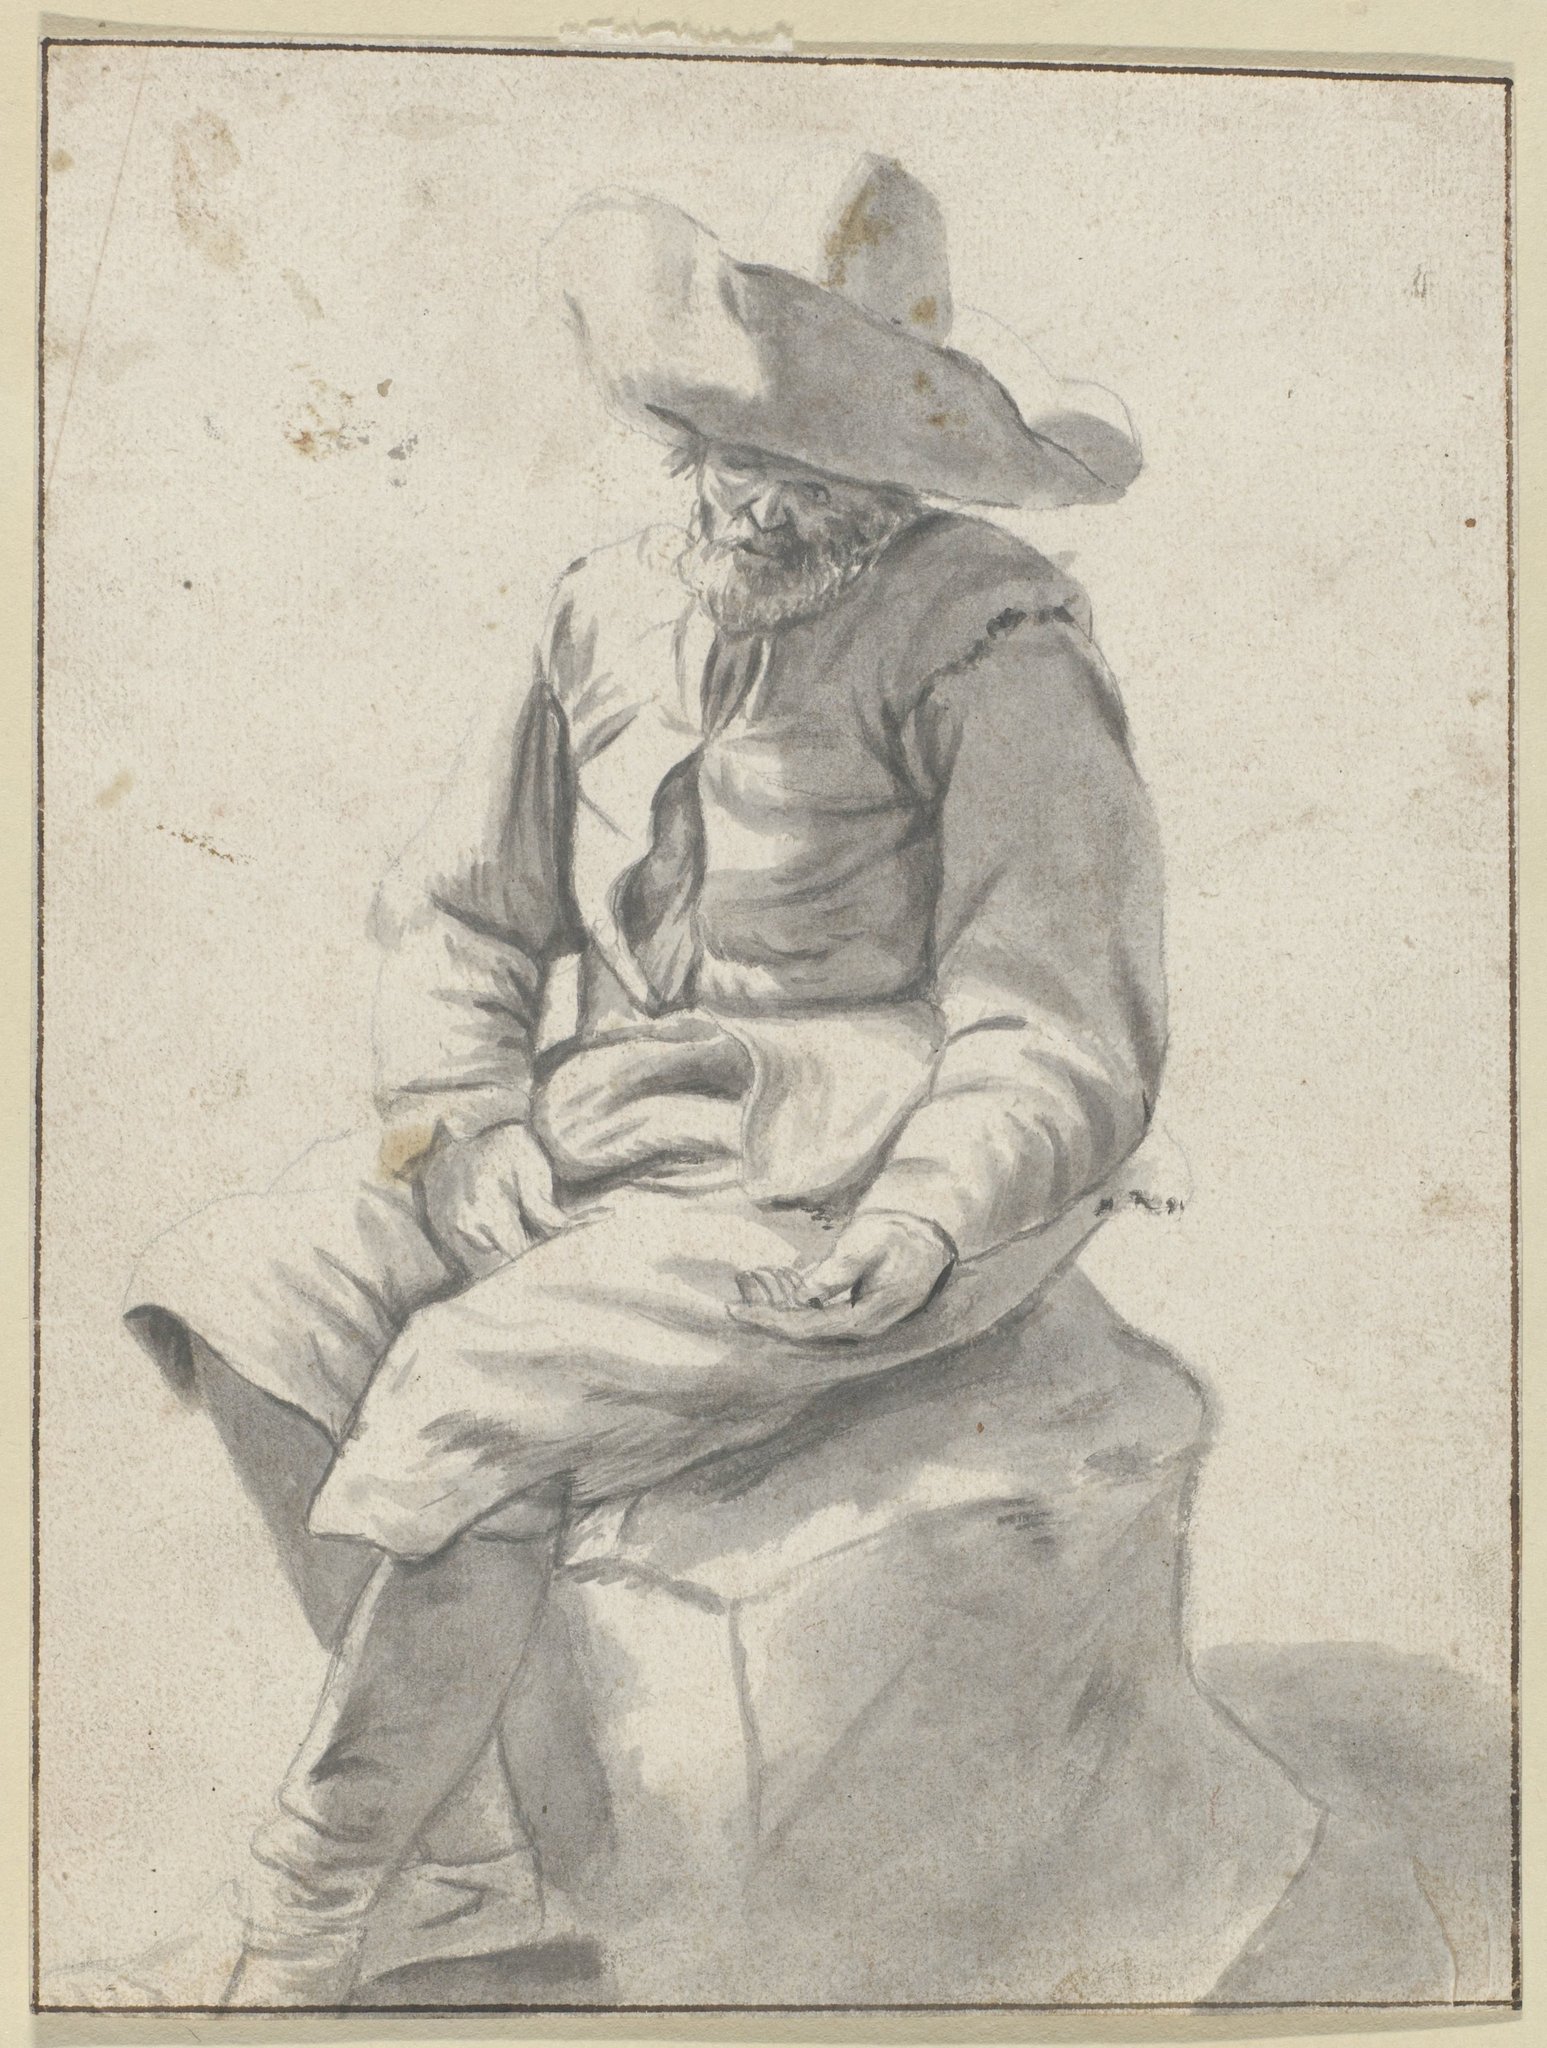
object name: drawing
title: Zittende man met hoed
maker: Anonymous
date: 1600-1699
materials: paper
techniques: brush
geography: netherlands